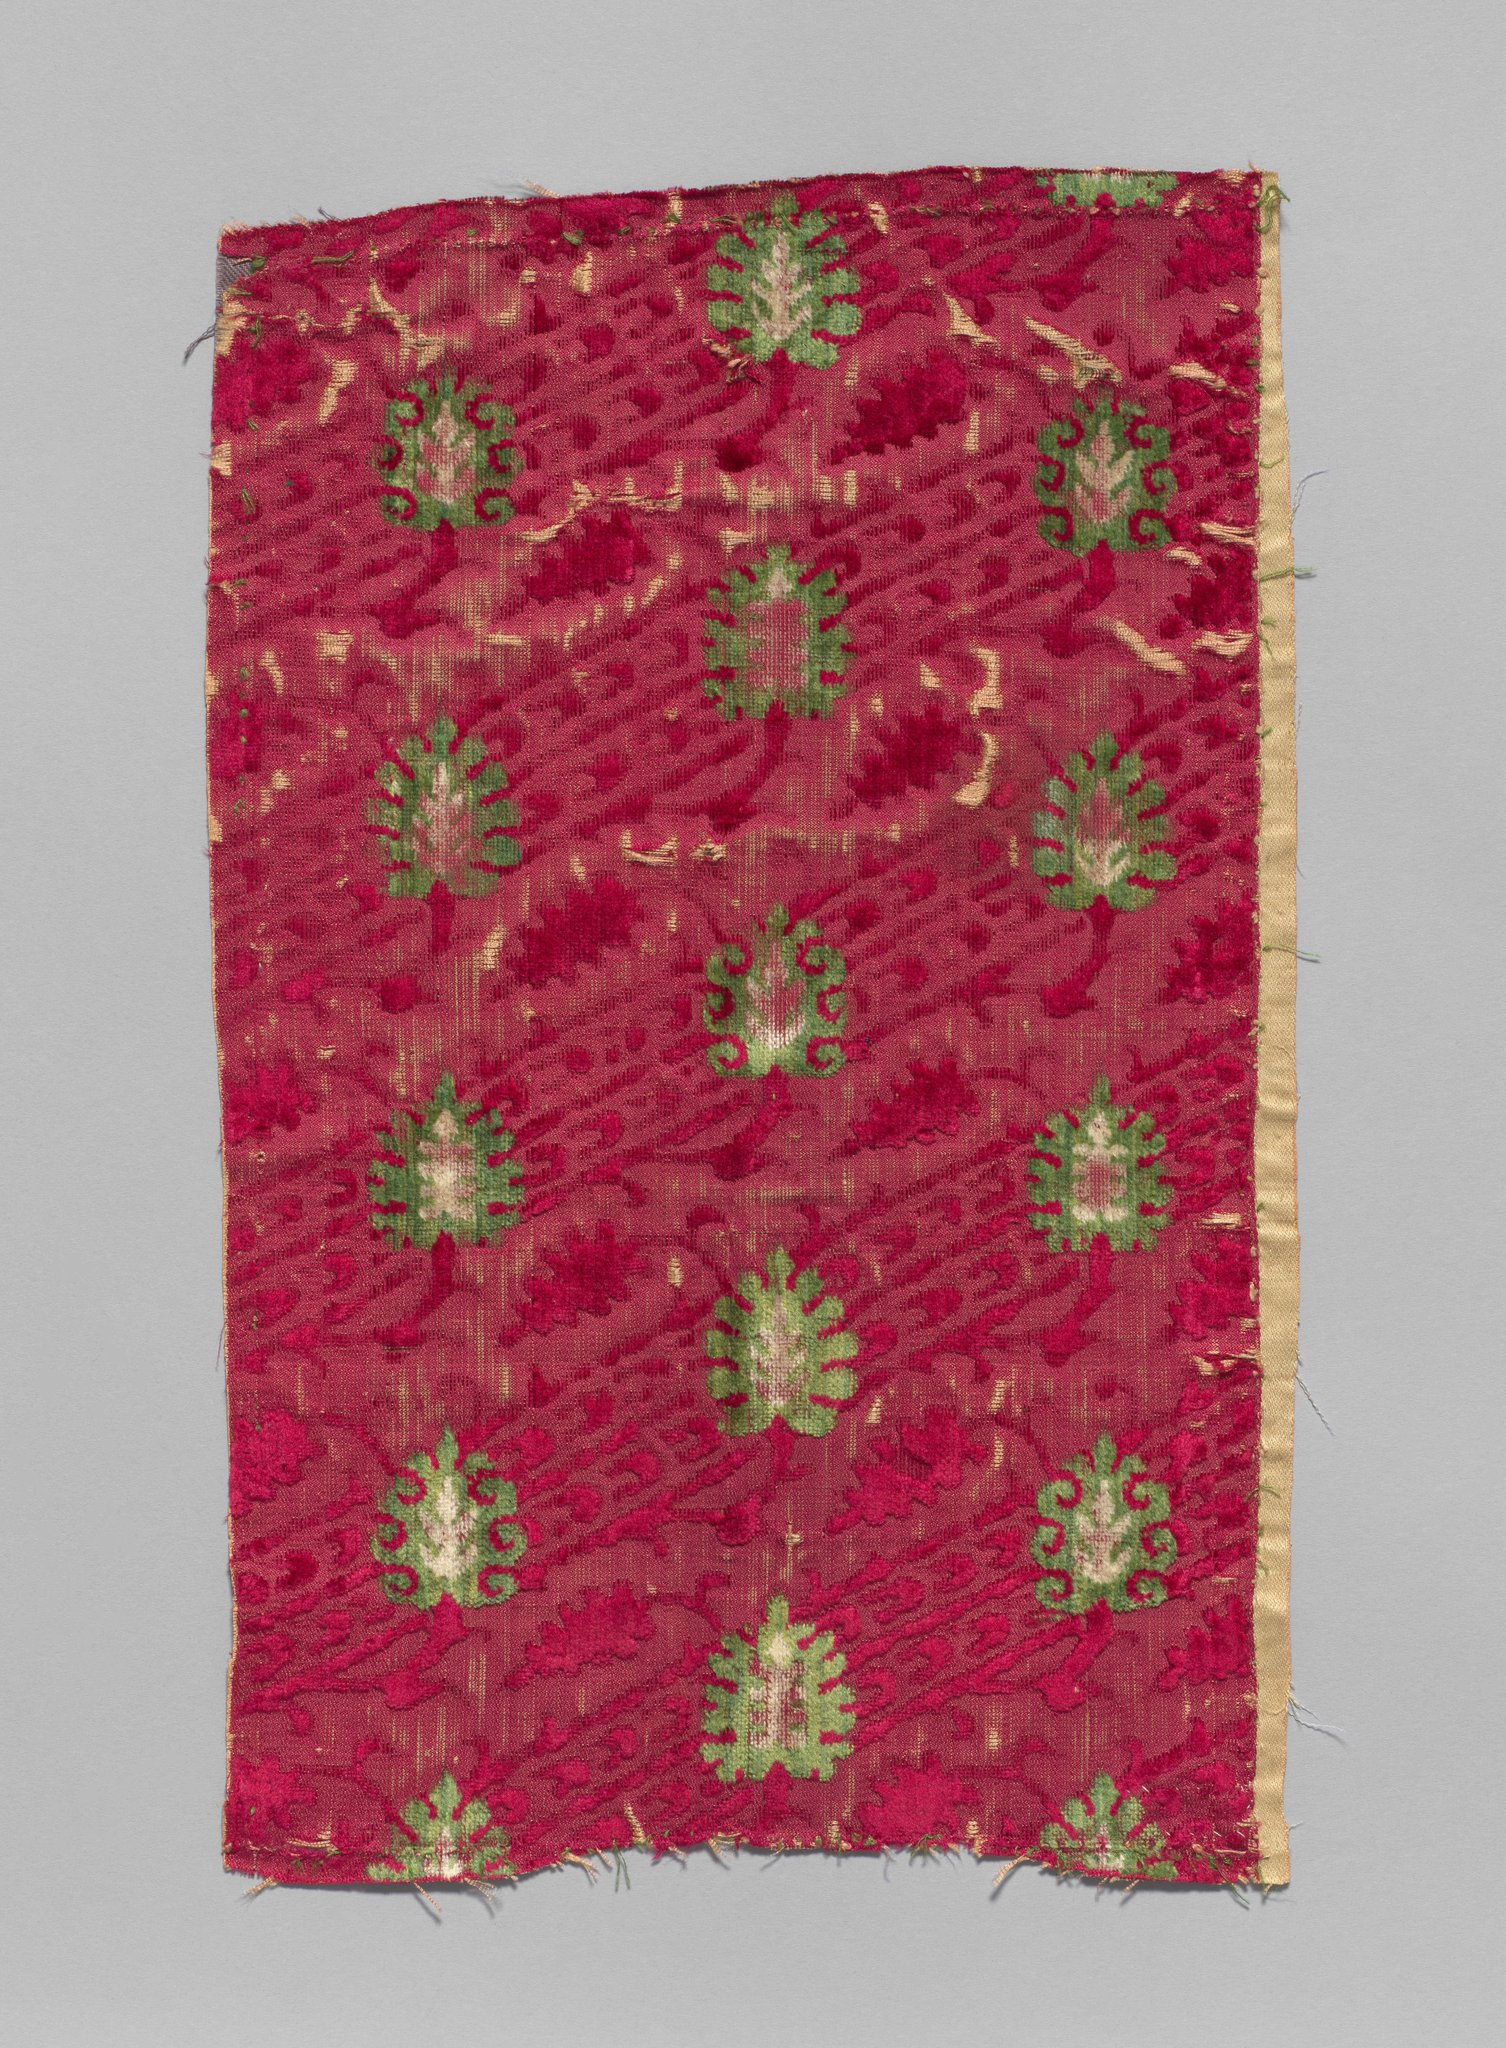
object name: panel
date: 1449-1459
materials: silk